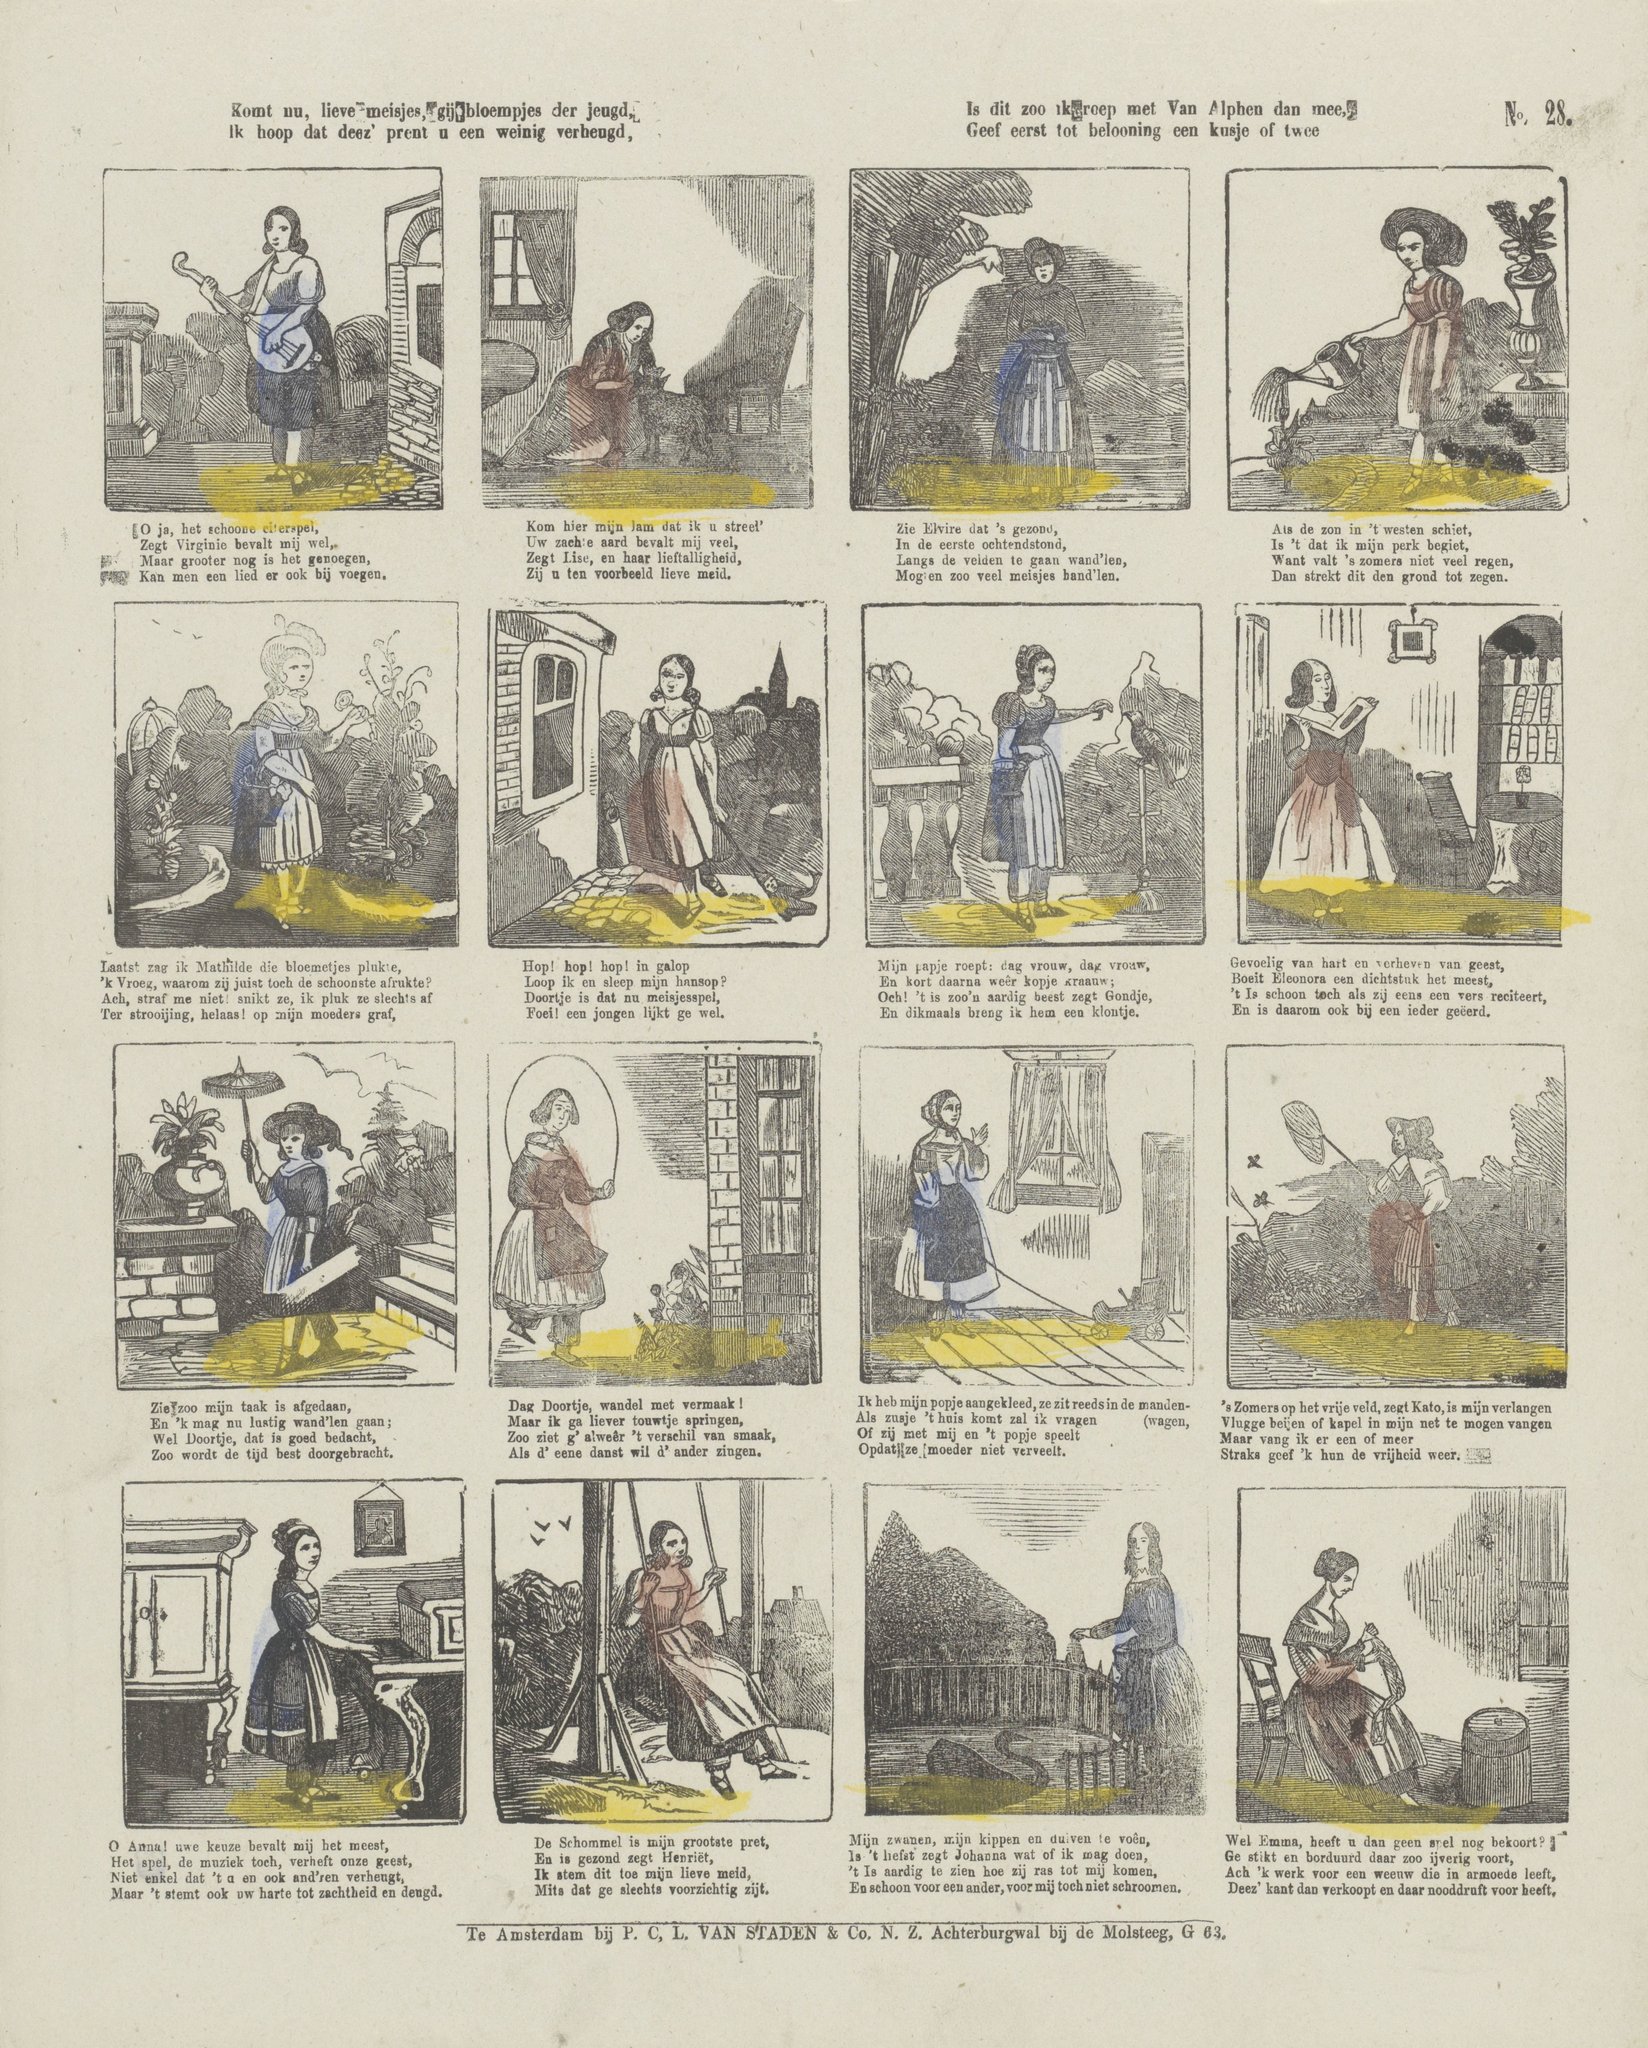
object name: print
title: Komt nu, lieve meisjes, gij bloempjes der jeugd, / Ik hoop dat deez' prent u een weinig verheugd. / Is dit zoo ik roep met Van Alphen dan meê, / Geef eerst tot belooning een kusje of twee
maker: Anonymous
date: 1850-1870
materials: paper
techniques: colour, letterpress printing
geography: amsterdam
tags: children's games and plays, walking, hiking (recreation), reading, swinging (children's game)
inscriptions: collector's mark: Lugt 2760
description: Blad met 16 voorstellingen van spelen en bezigheden voor meisjes, zoals wandelen, touwtjespringen en schommelen. Onder elke afbeelding een vierregelig vers. Rechtsboven genummerd: No. 28.